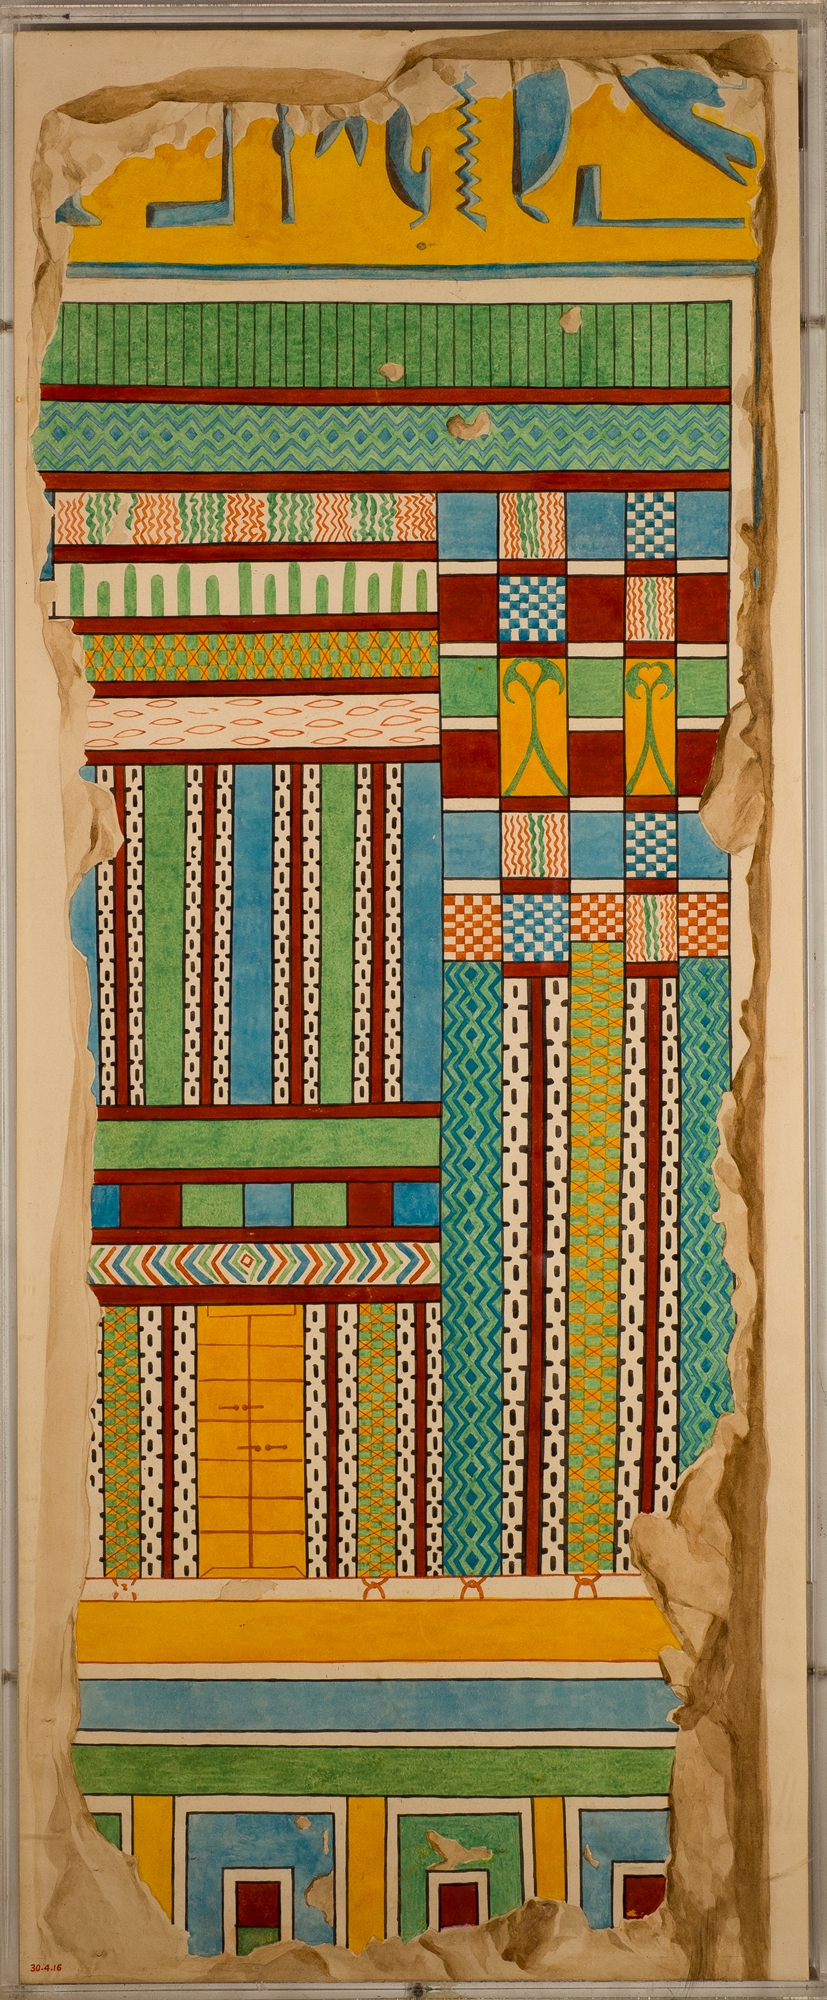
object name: facsimile, puyemre tt 39, ceiling decoration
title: Decoration of a Vaulted Ceiling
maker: hugh r. hopgood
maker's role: artist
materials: paper, paint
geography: egypt